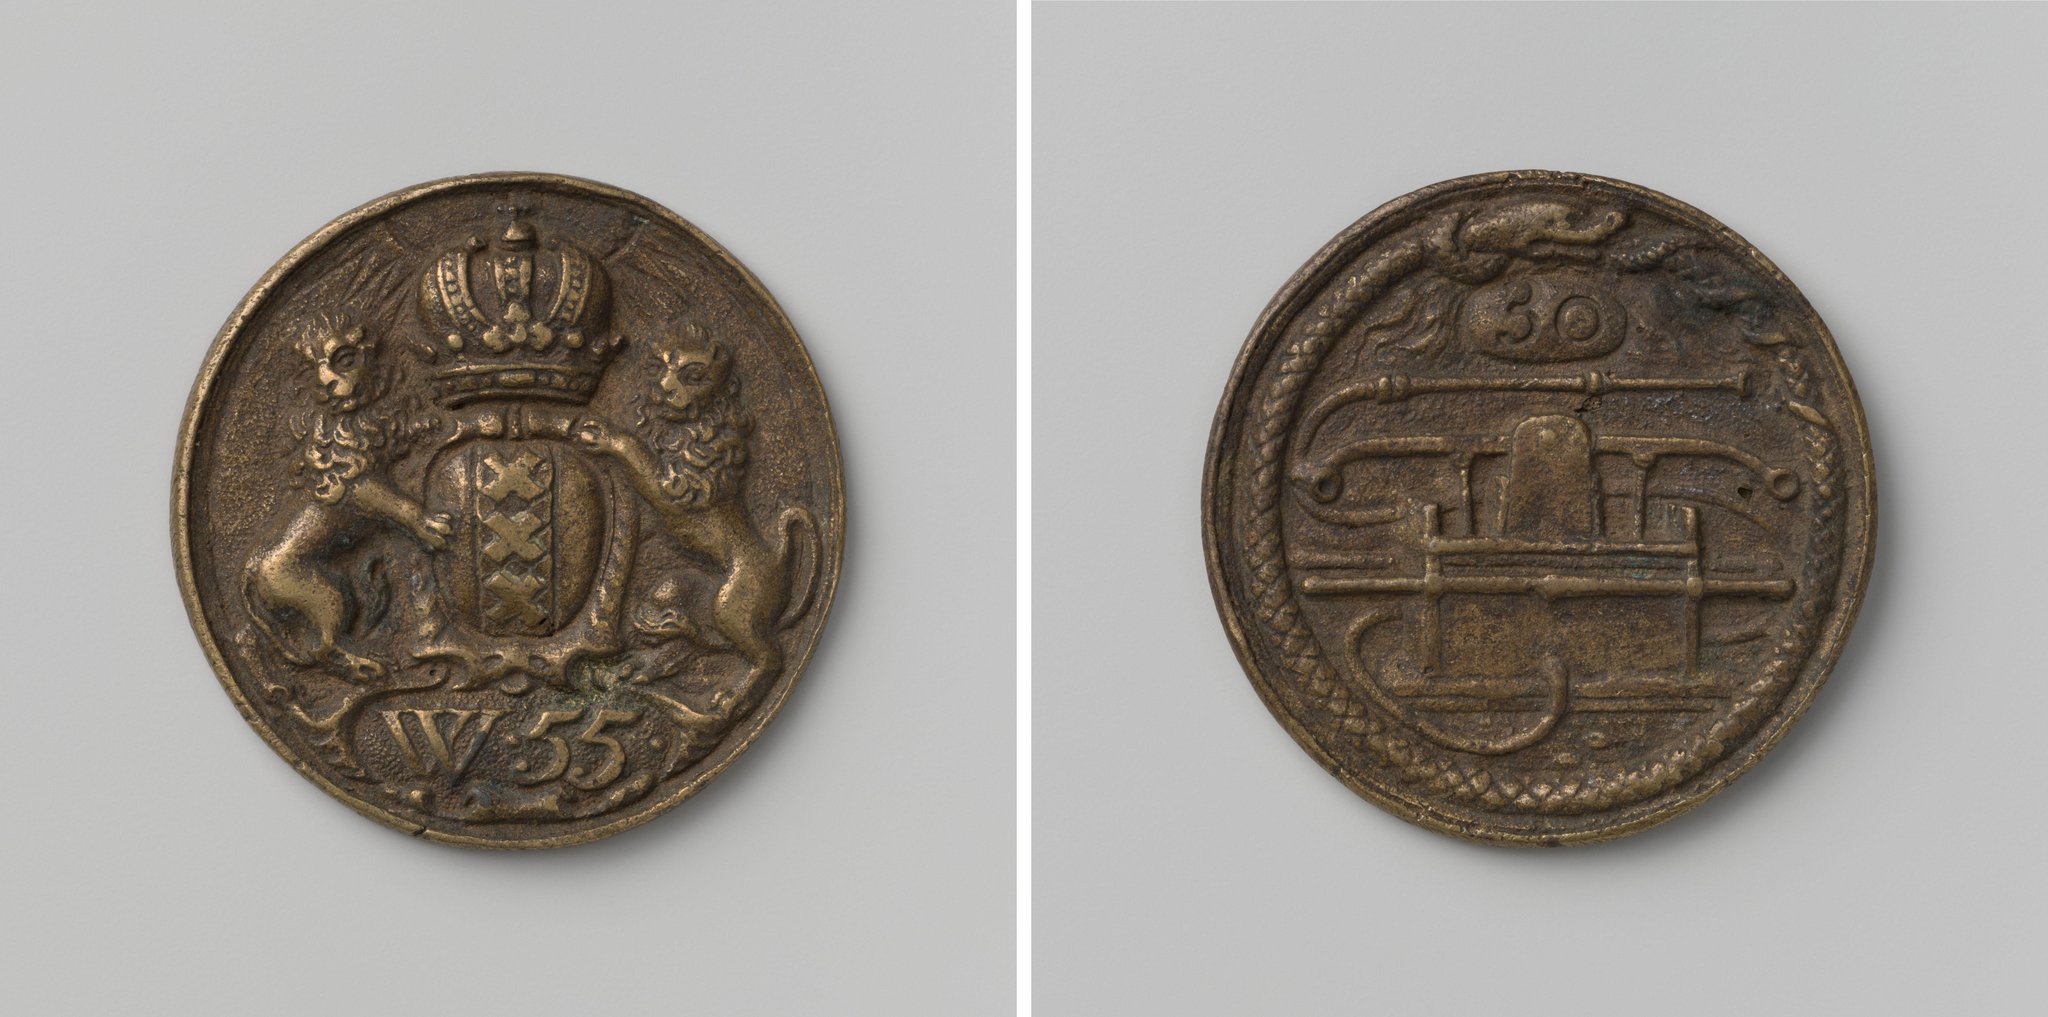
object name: fire engine medal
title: Amsterdam, brandspuitpenning van wijk 55 met no. 30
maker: Anonymous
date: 1680-1800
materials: brass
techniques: casting, engraving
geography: amsterdam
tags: amsterdam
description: Messing penning. Voorzijde: gekroond wapenschild, geflankeerd door twee leeuwen boven cartouche met opschrift W 55. Keerzijde: brandspuit onder cartouche met no. 30 binnen slangerond